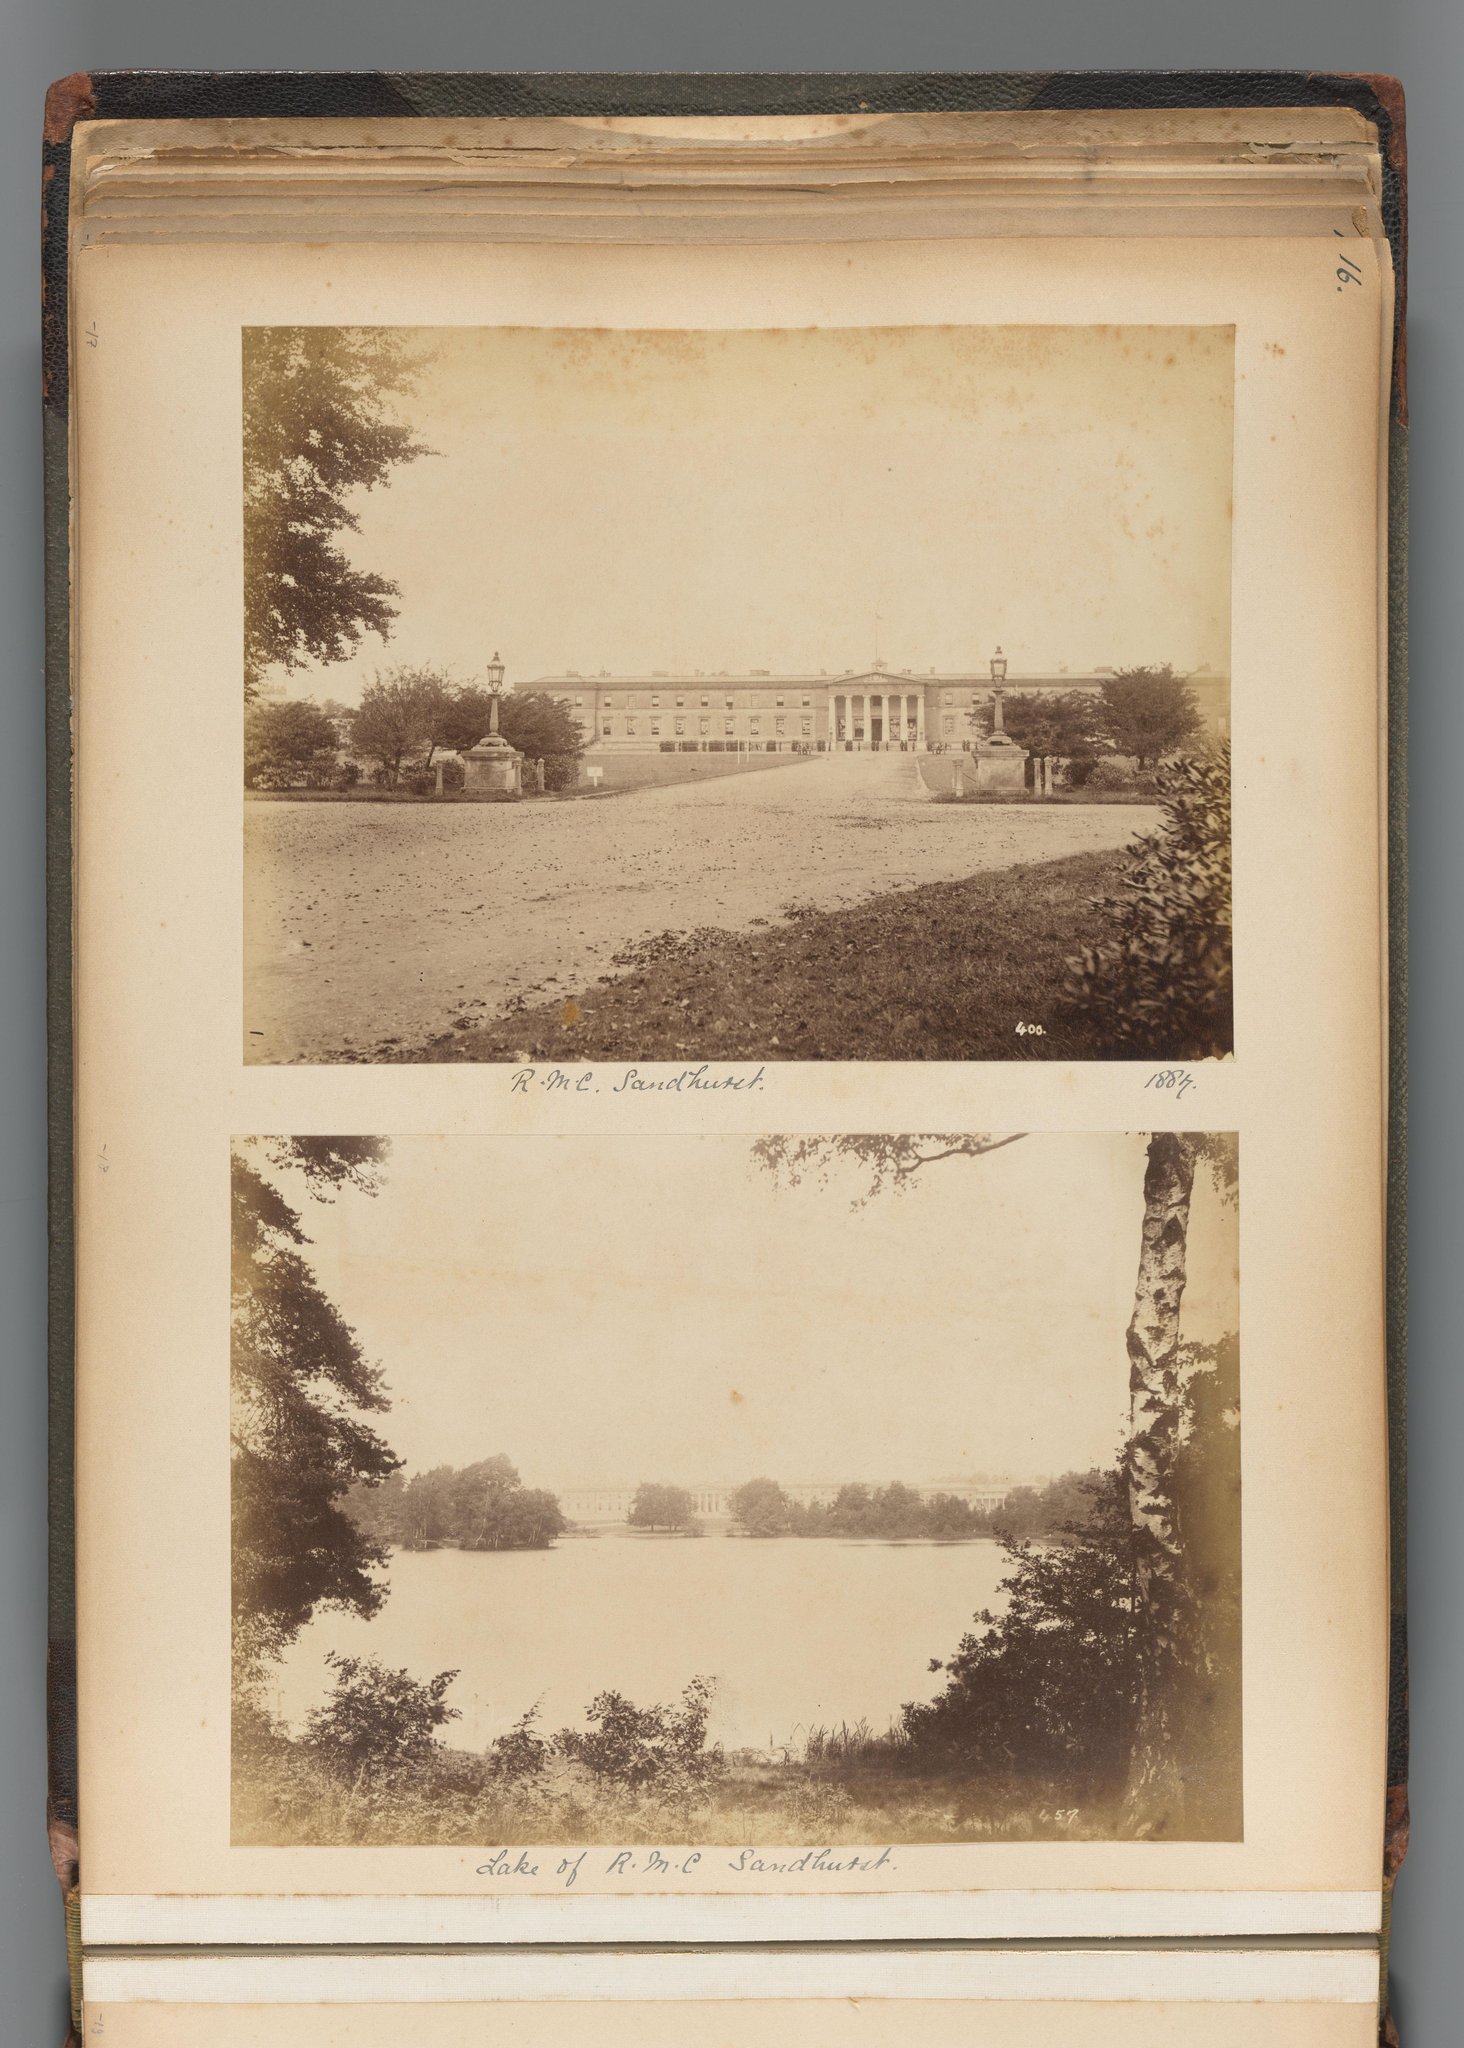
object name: album leaf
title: Gezicht op de Koninklijke Militaire Academie Sandhurst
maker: c.c. blackburn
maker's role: fotograaf, luitenant-kolonel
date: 1887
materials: paper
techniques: albumen print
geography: camberley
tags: military academy, royal military academy sandhurst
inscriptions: number: ‘400.’